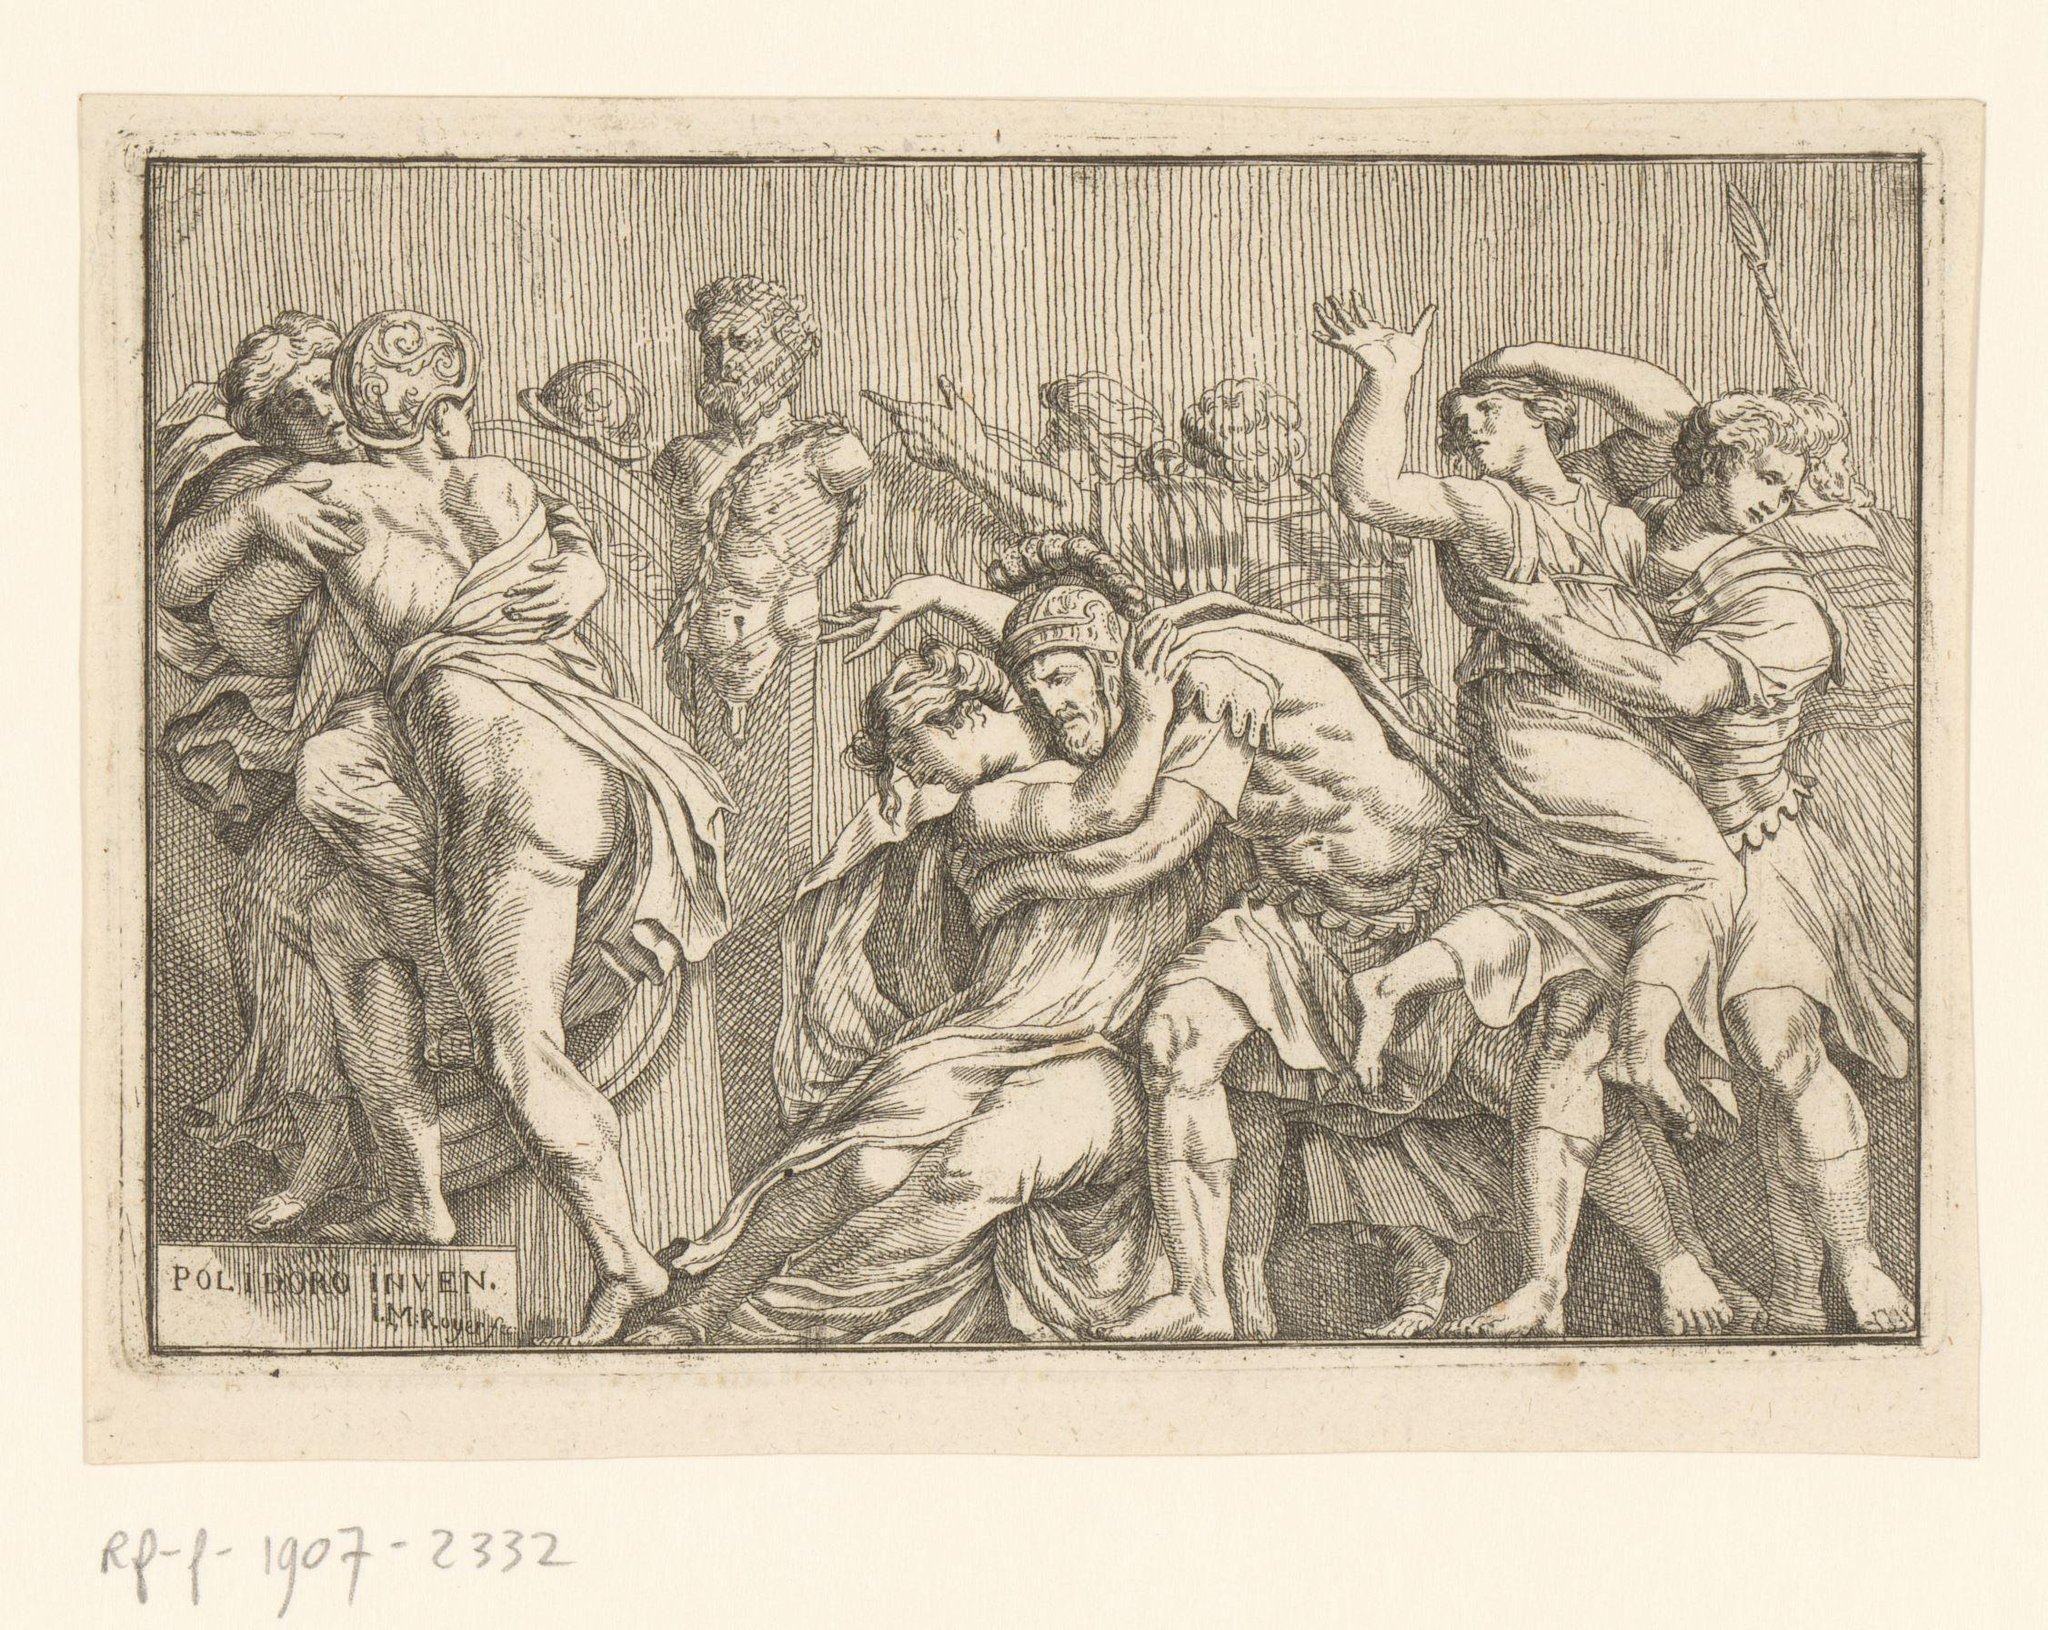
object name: print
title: Mythologisch-historische scene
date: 1765-1799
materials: paper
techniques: etching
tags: classical mythology and ancient history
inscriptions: collector's mark: Lugt 2228